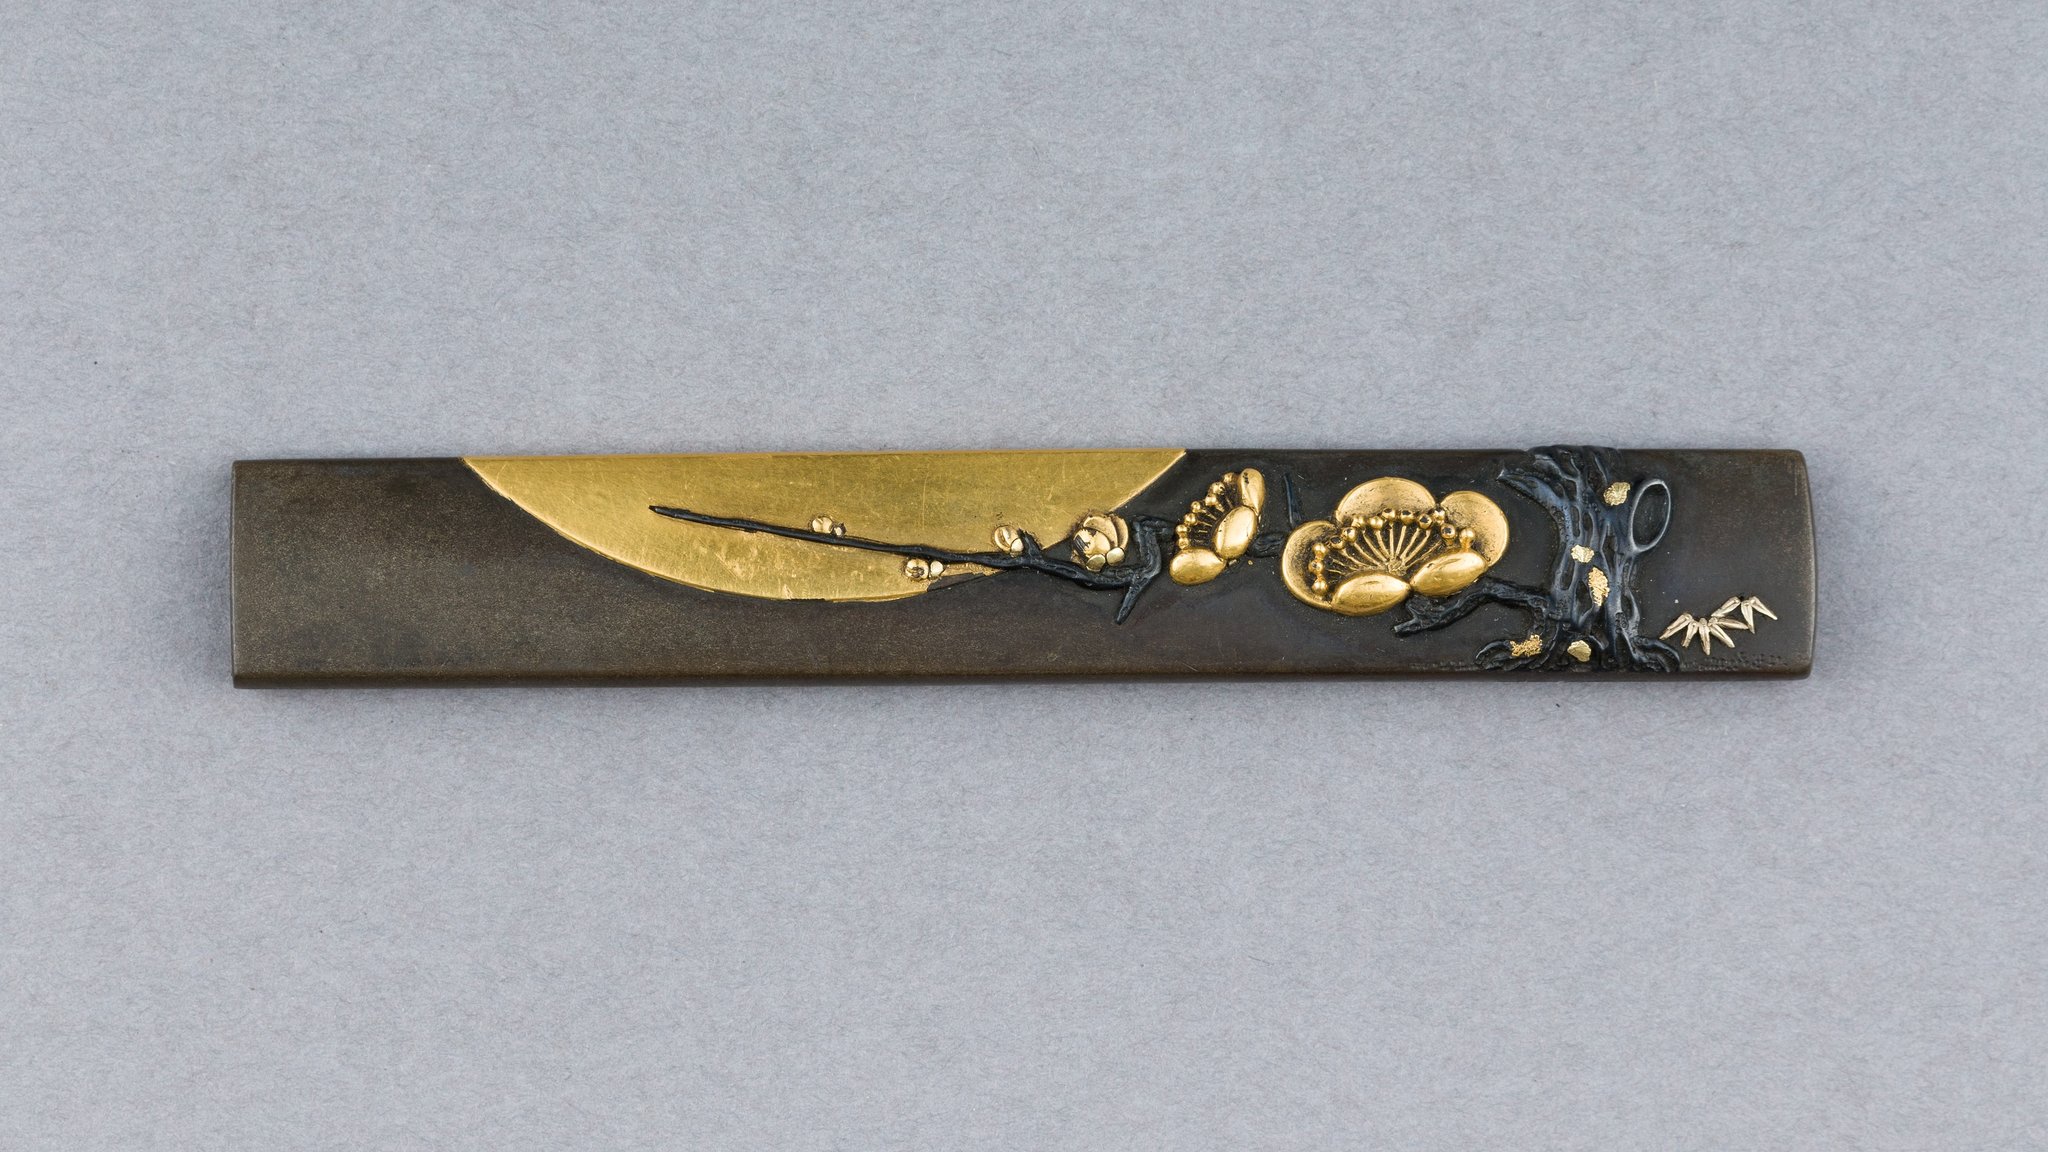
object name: knife handle kozuka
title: Knife Handle (Kozuka)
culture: japanese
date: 1615-1868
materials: silver alloy, gold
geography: japan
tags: flowers